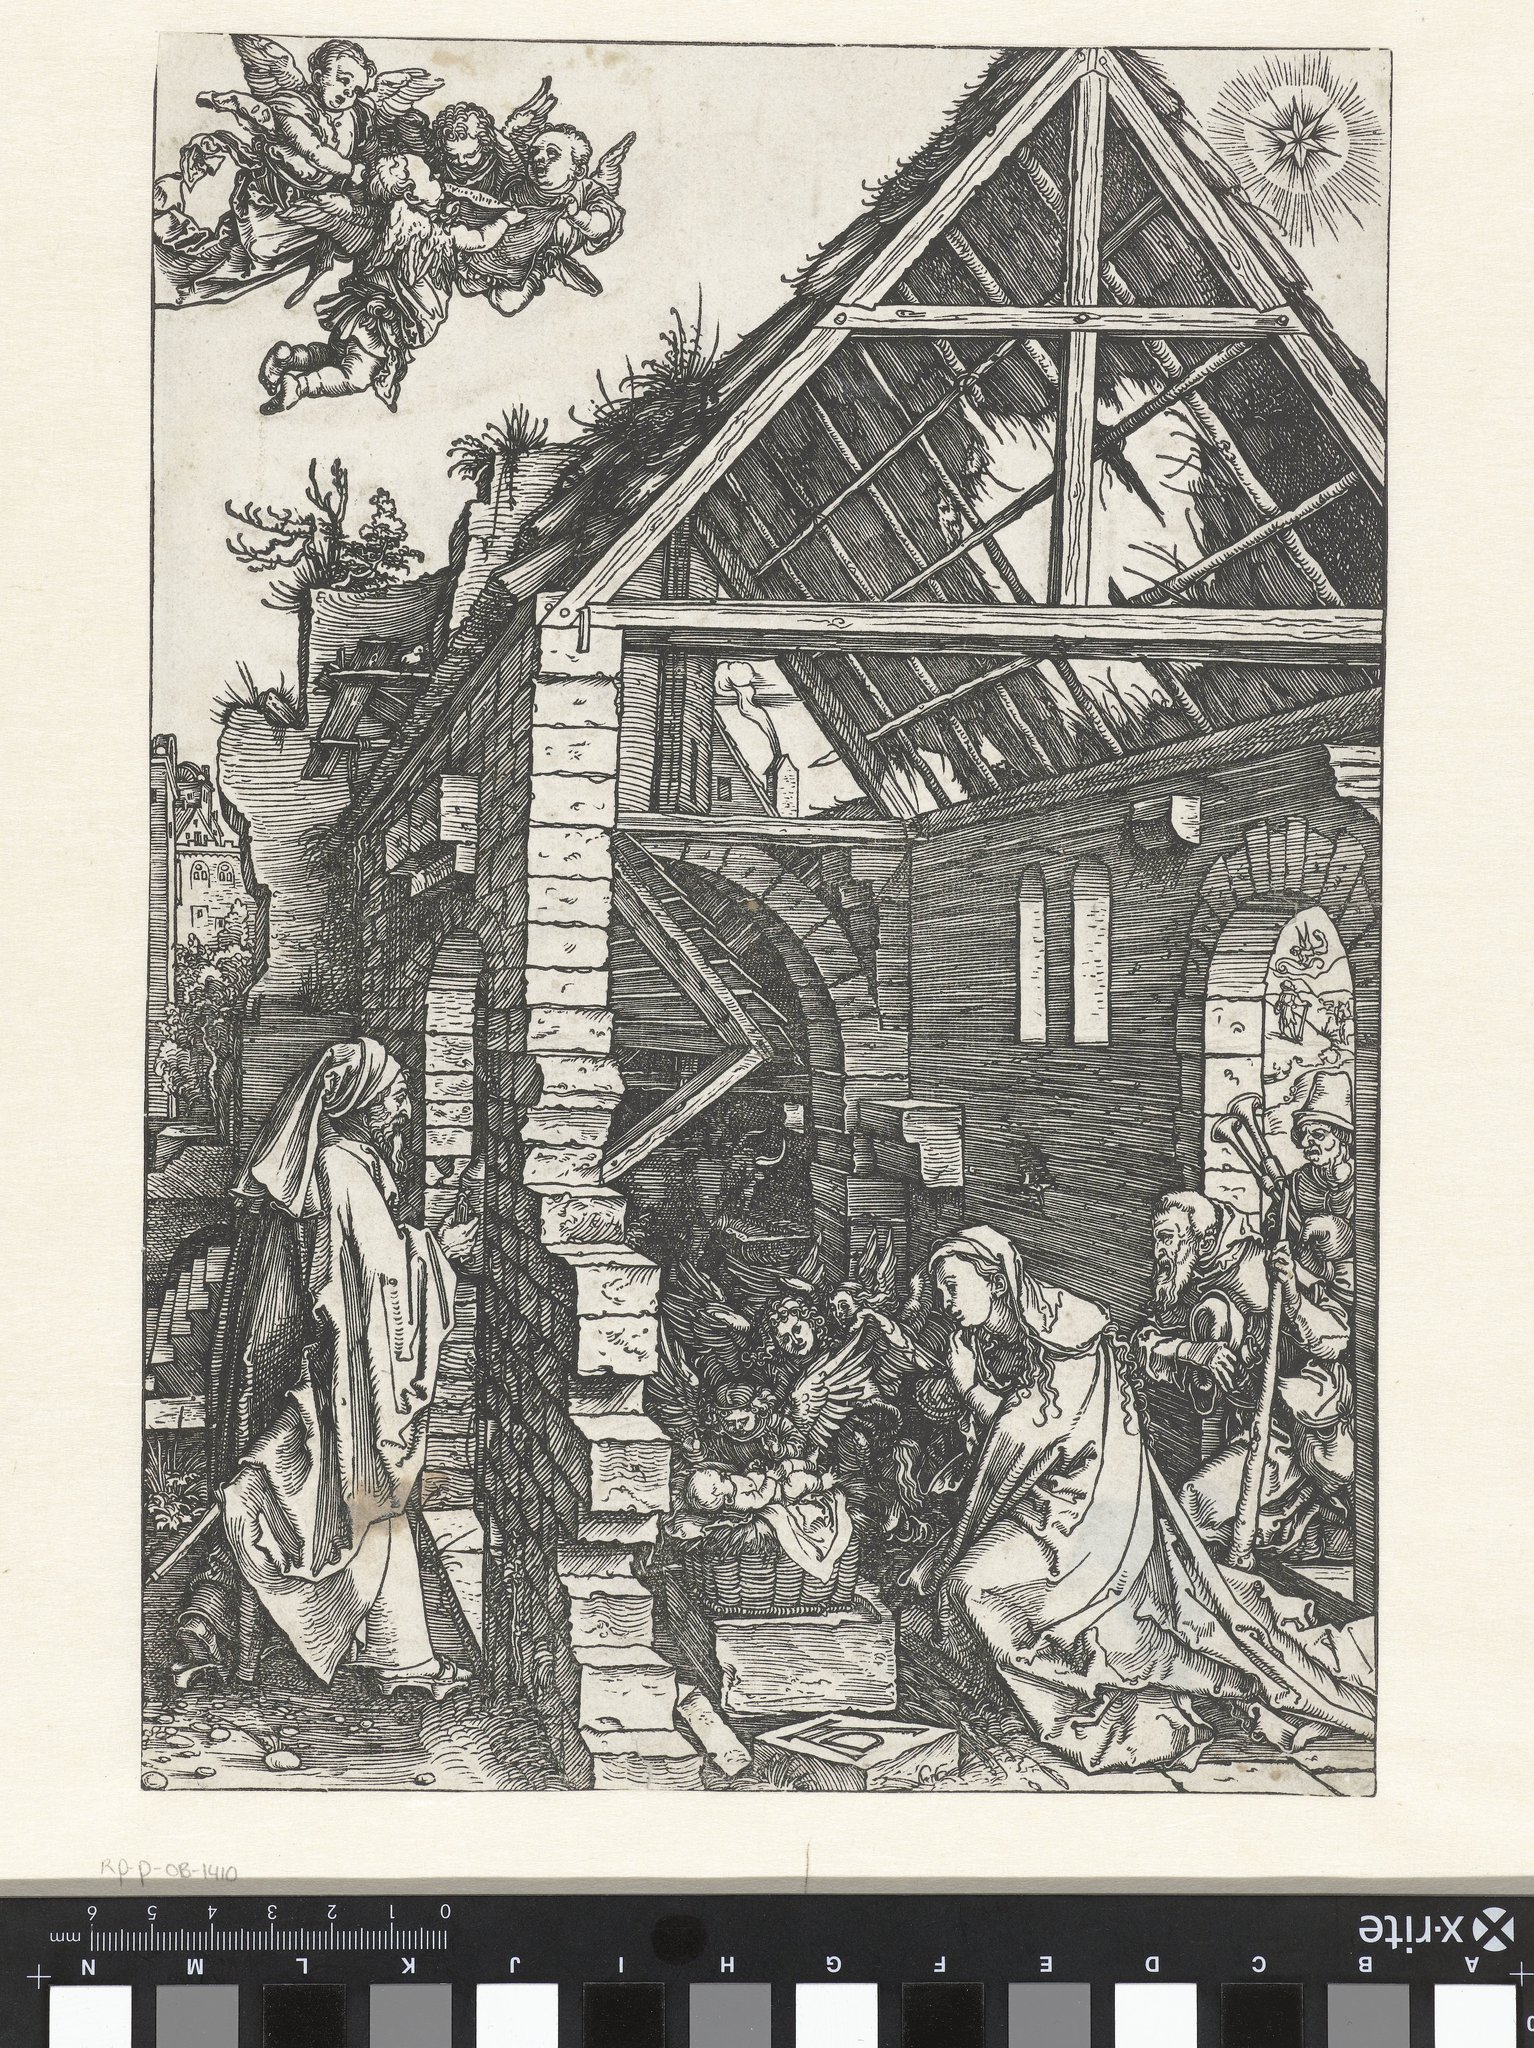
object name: print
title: Aanbidding door de herders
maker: albrecht dürer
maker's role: draughtsman, painter, print maker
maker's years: 1471-1528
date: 1502-1503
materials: paper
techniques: woodcut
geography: nuremberg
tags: adoration of the christ-child by the shepherds; mary and joseph present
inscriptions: collector's mark: Lugt 240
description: In een vervallen huis knielt Maria bij haar kind. Engeltjes staan naast haar. Herders komen door een deur achter haar binnen, Jozef door een deur voor haar. Deze prent is onderdeel van een serie van 20 prenten, bestaand uit een titelprent en 19 prenten met scènes uit het leven van Maria.